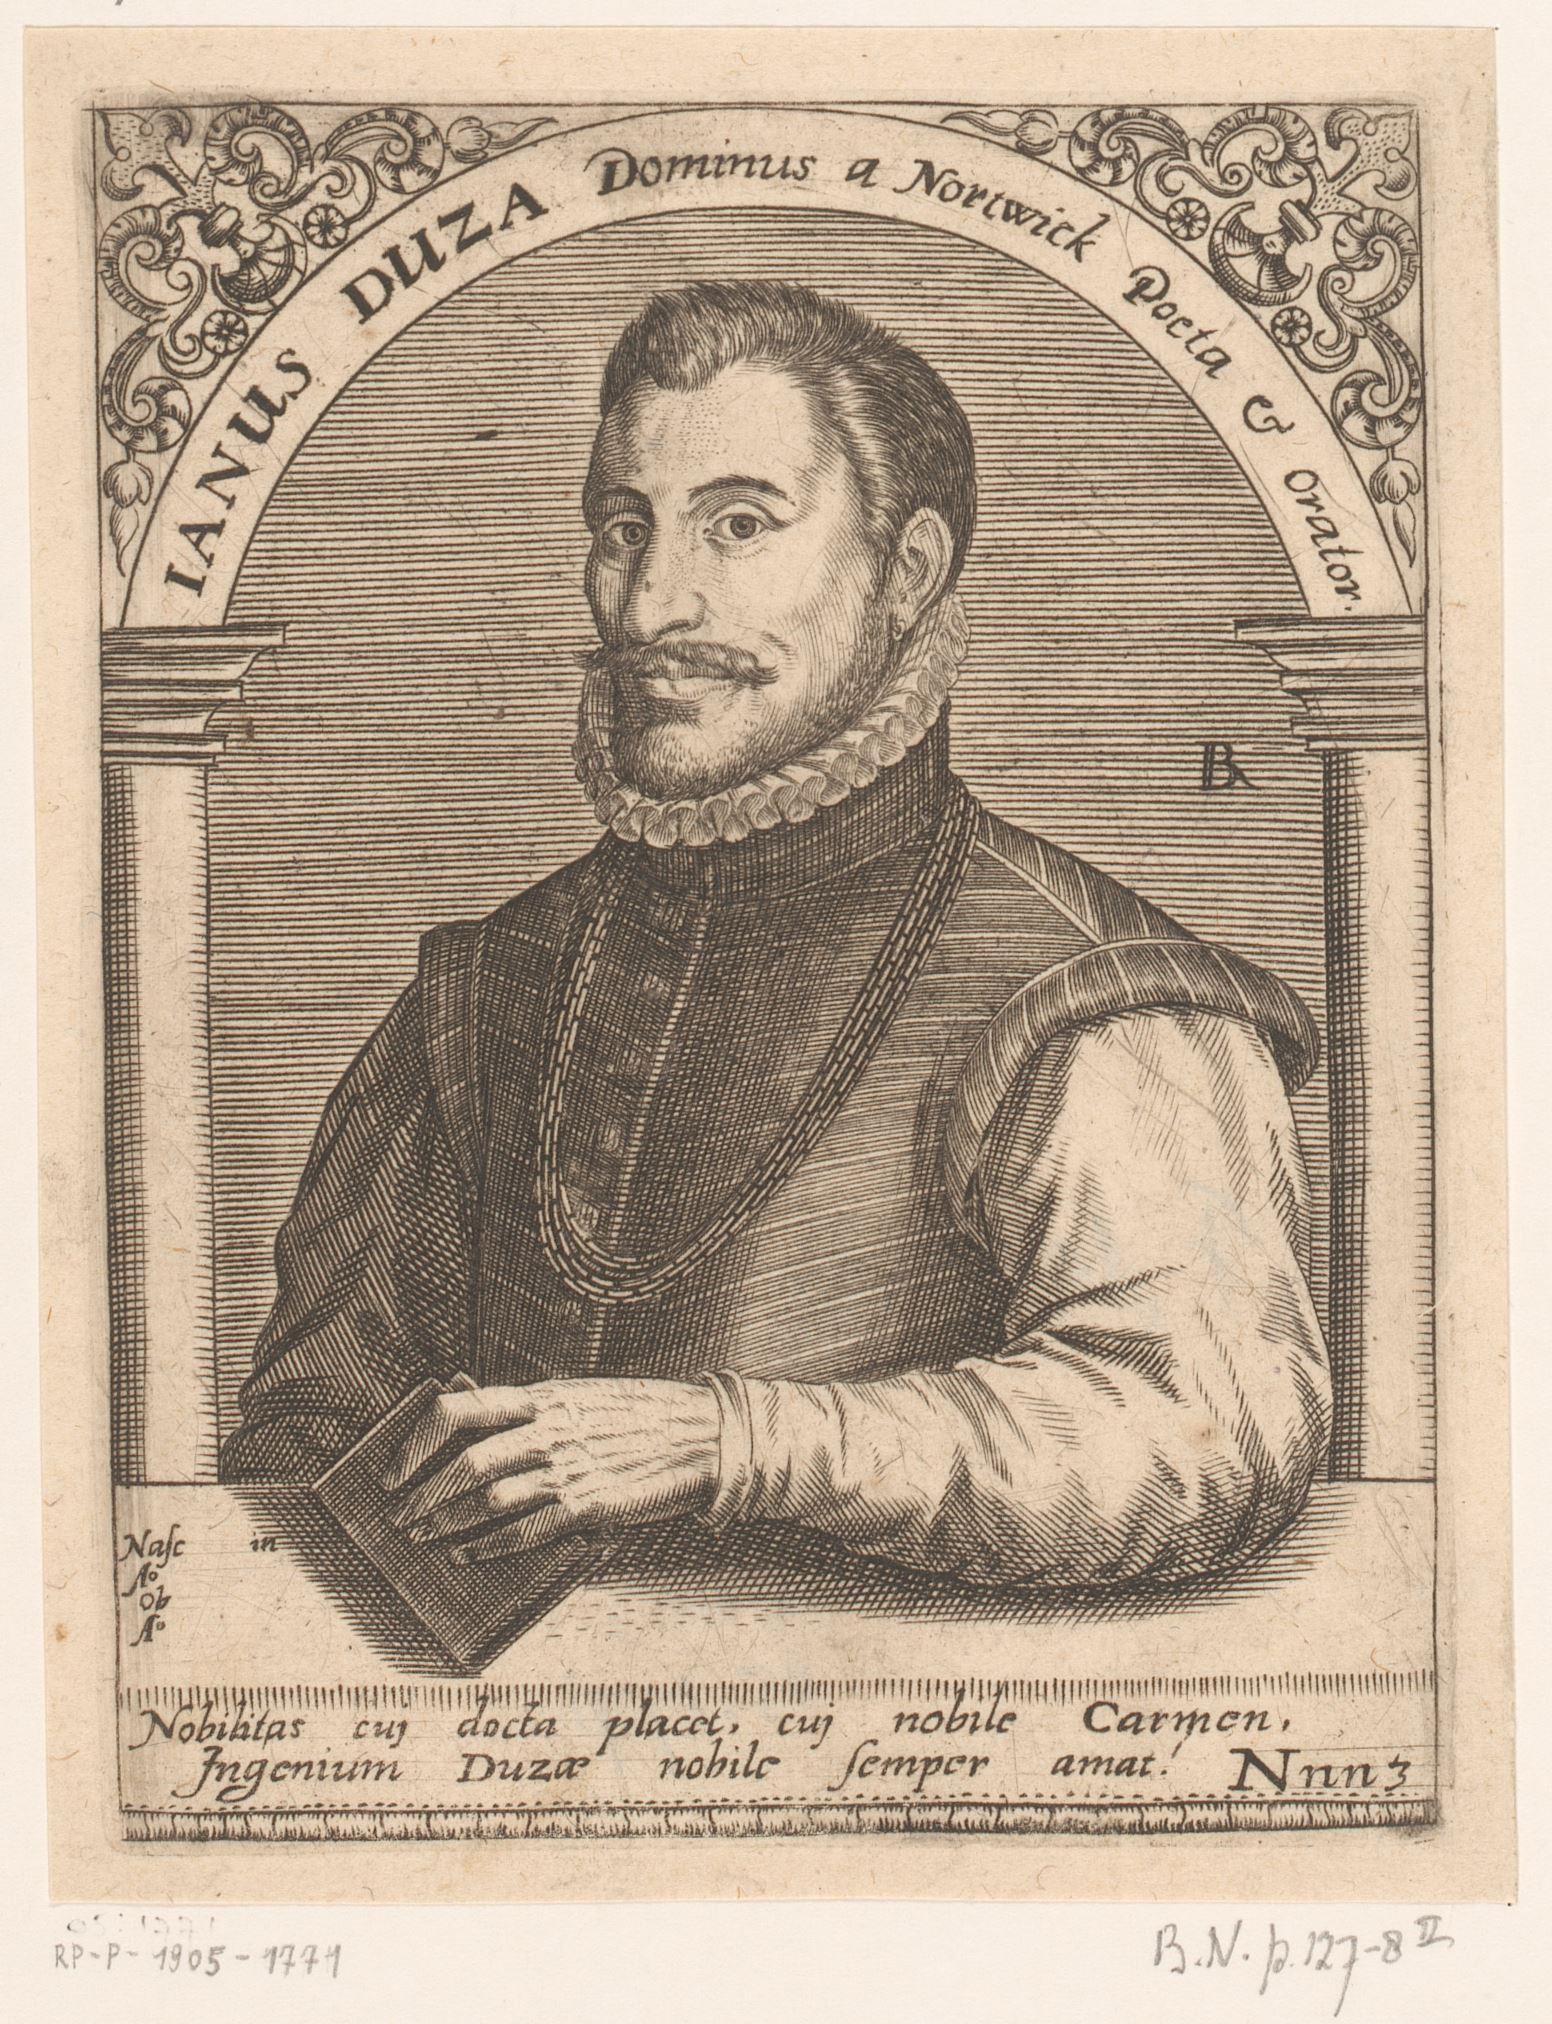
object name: print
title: Serie portretten van vijftiende- en zestiende-eeuwse geleerden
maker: robert boissard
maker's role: print maker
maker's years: 1570-1611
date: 1597-1599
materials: paper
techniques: engraving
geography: france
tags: the hague, janus dousa (jr.), historical persons, book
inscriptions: collector's mark: Lugt 2228